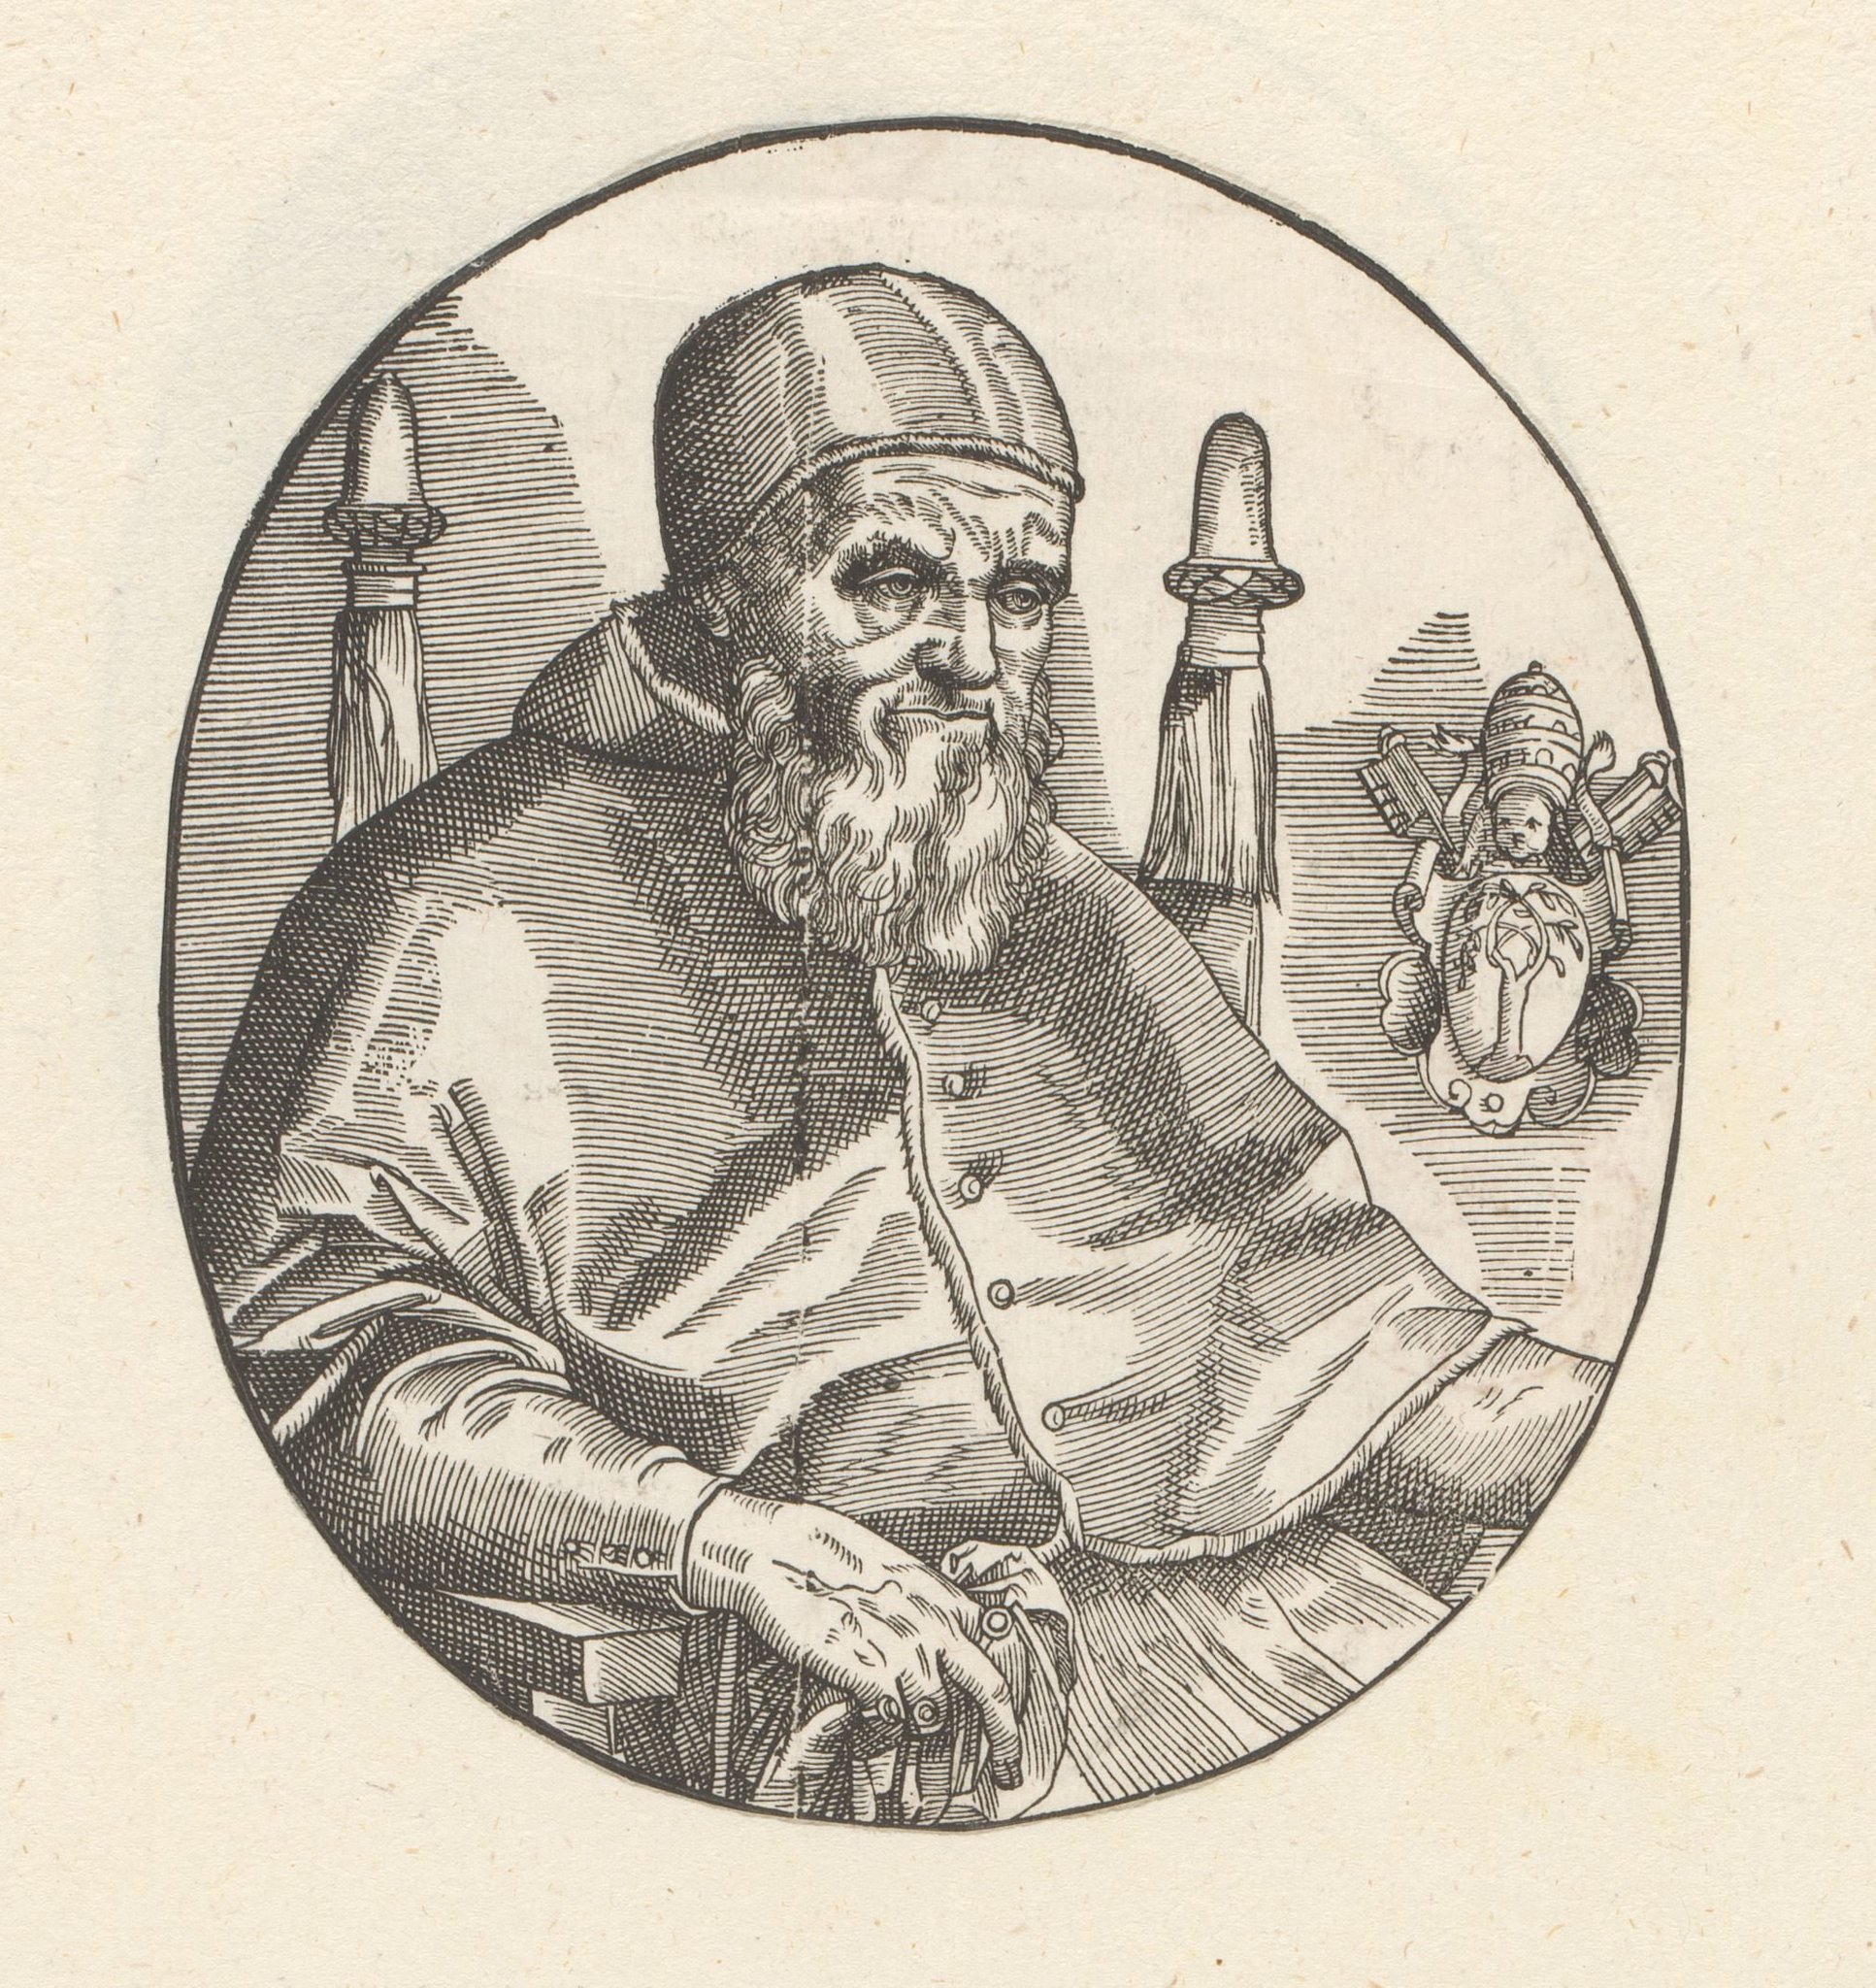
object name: print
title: Portret van paus Julius II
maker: Anonymous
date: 1549-1573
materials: paper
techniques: woodcut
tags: rome, historical persons, pope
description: Prent gebruikt in: Panvinio, Onofrio. Accuratae Effigies Pontificum (...). Straatsburg: Bernhard Jobin, 1573.